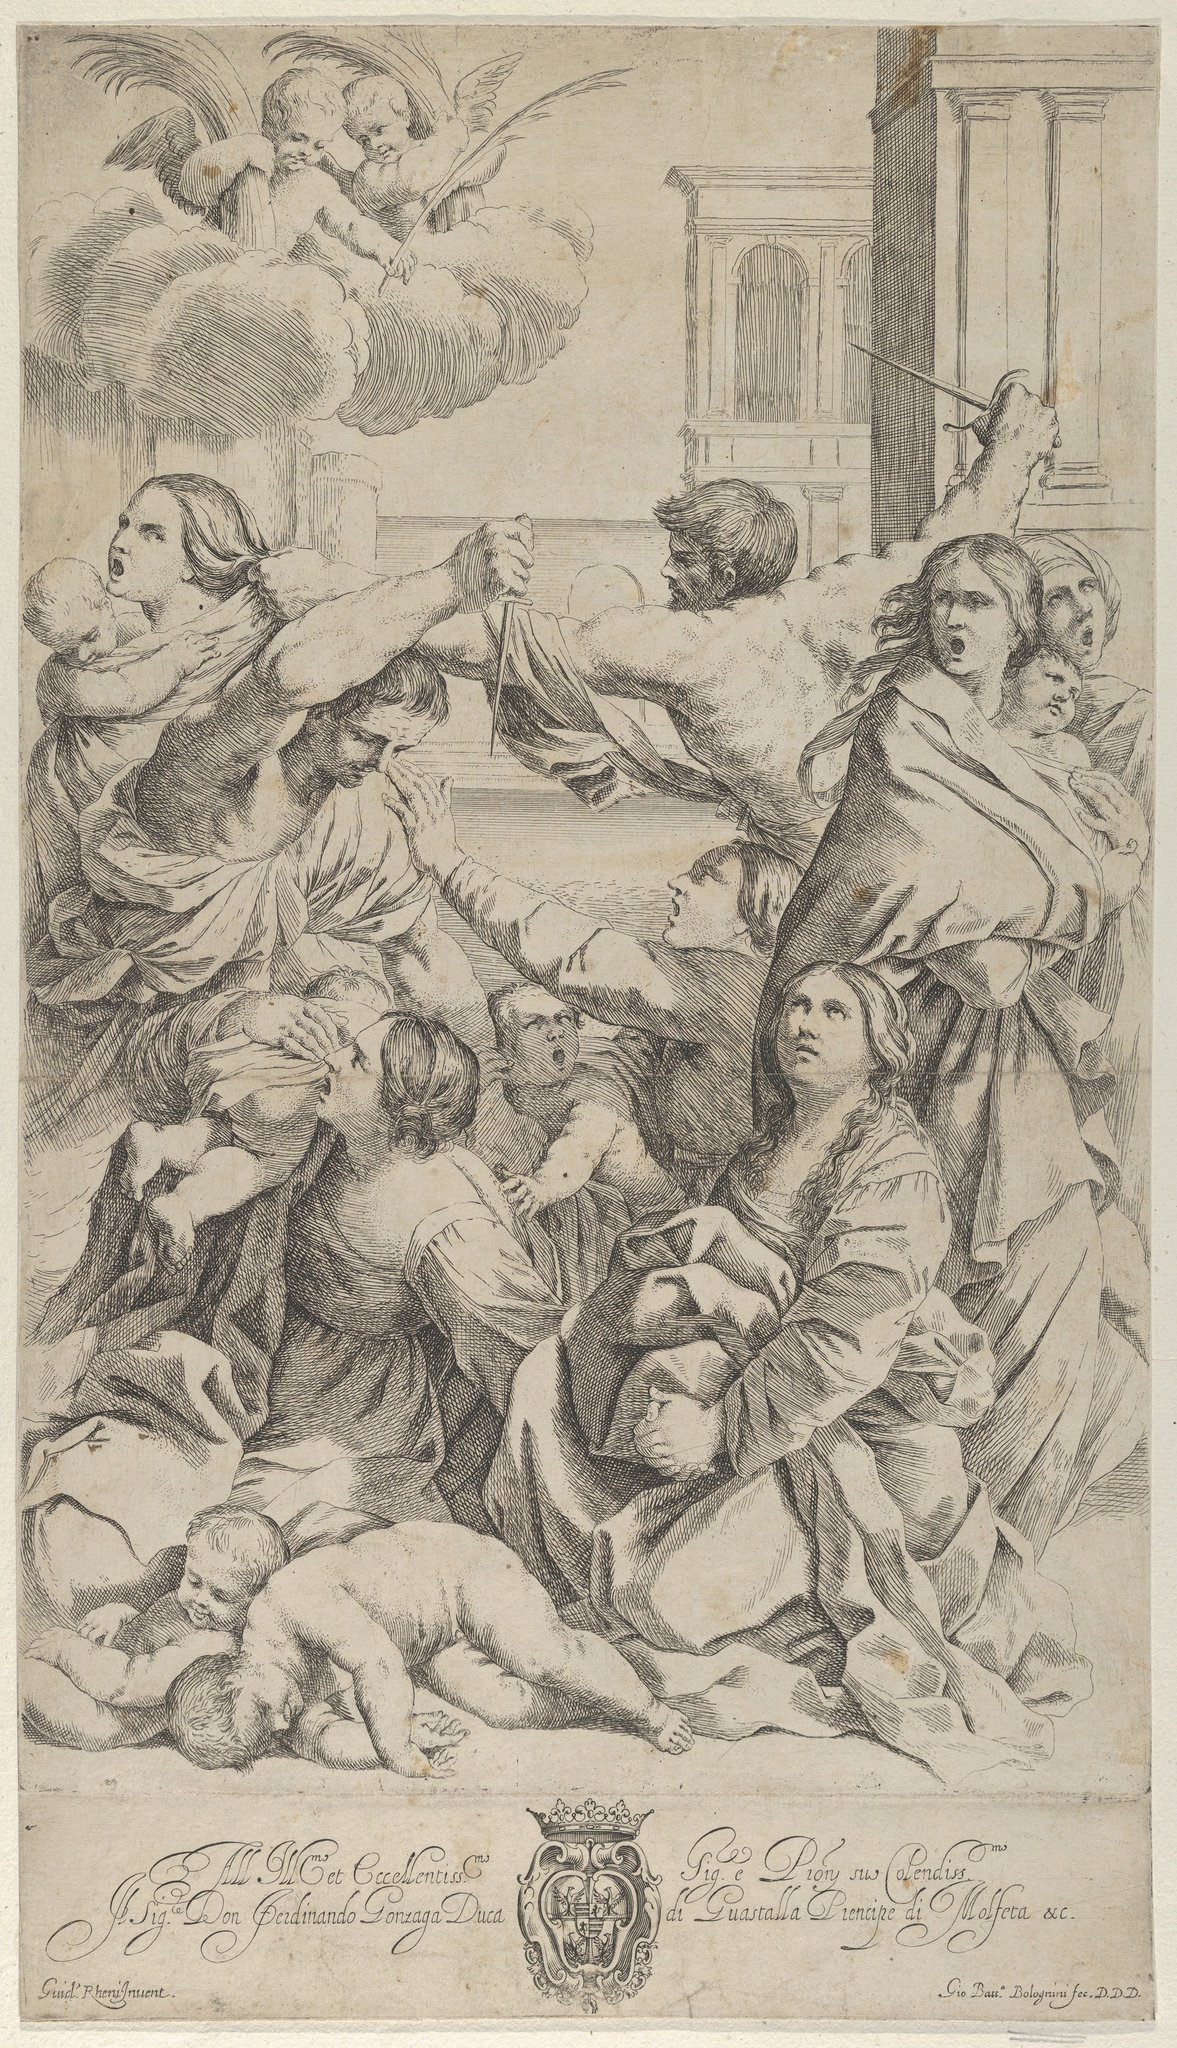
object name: print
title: Massacre of the Innocents; group of women and children being attacked, two angels at upper left, after Reni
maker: gian battista bolognini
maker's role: artist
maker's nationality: italian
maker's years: 1611-1688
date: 1640-1670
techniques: etching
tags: massacres,men,women,angels,coat of arms